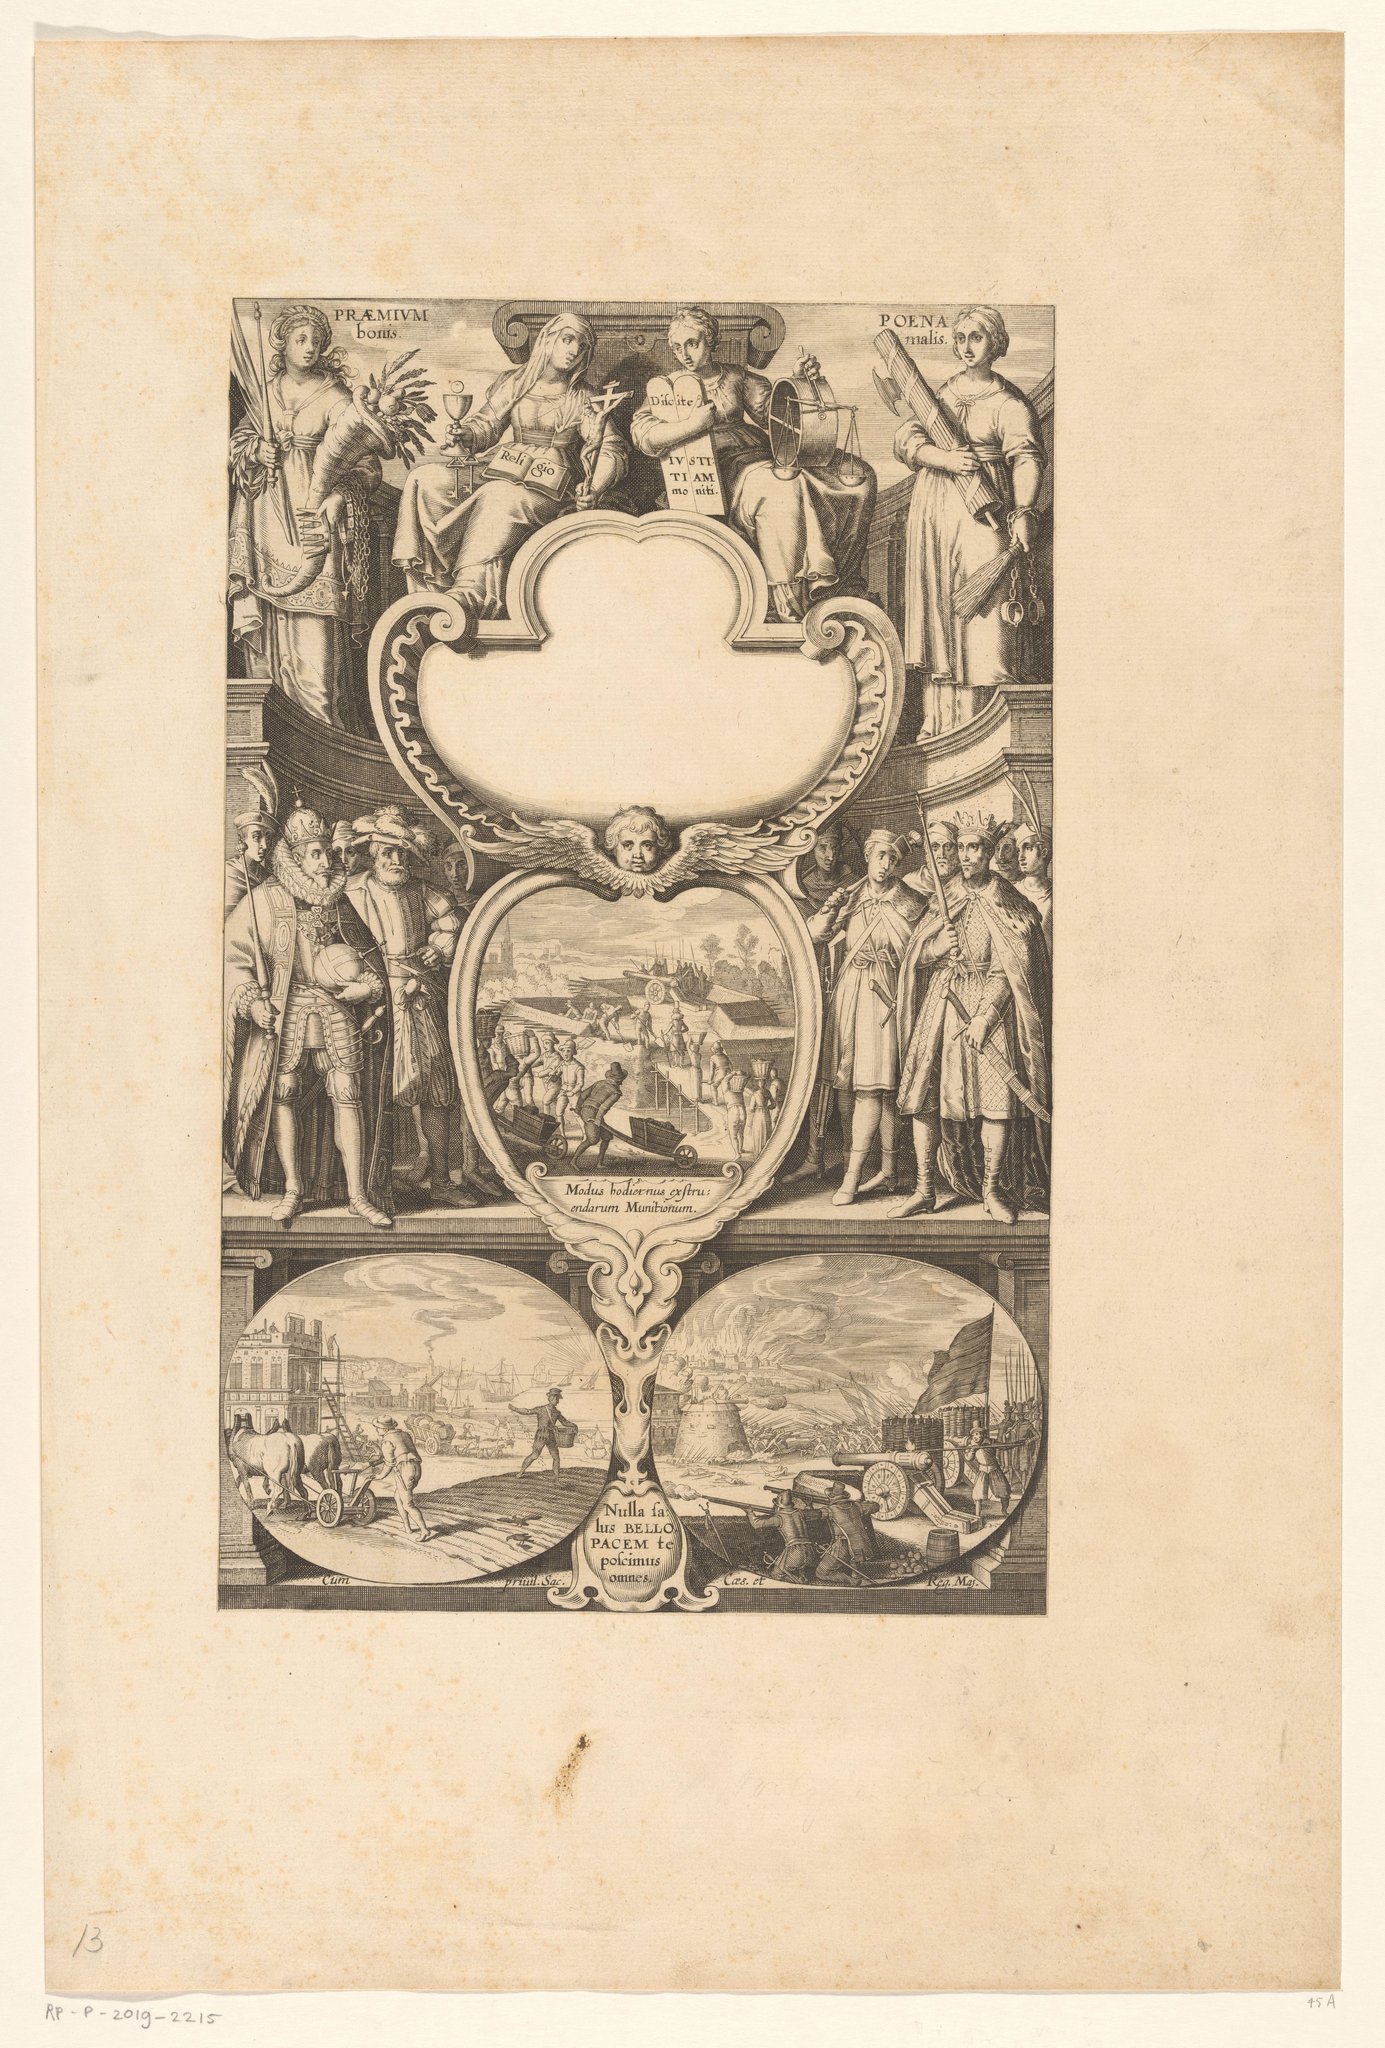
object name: print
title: Allegorie op goed bestuur en vrede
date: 1600-1699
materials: paper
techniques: engraving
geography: netherlands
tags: war and peace, king, good government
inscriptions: collector's mark: Lugt 2228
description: Waarschijnlijk betreft dit een titelpagina voor een onbekend boek.